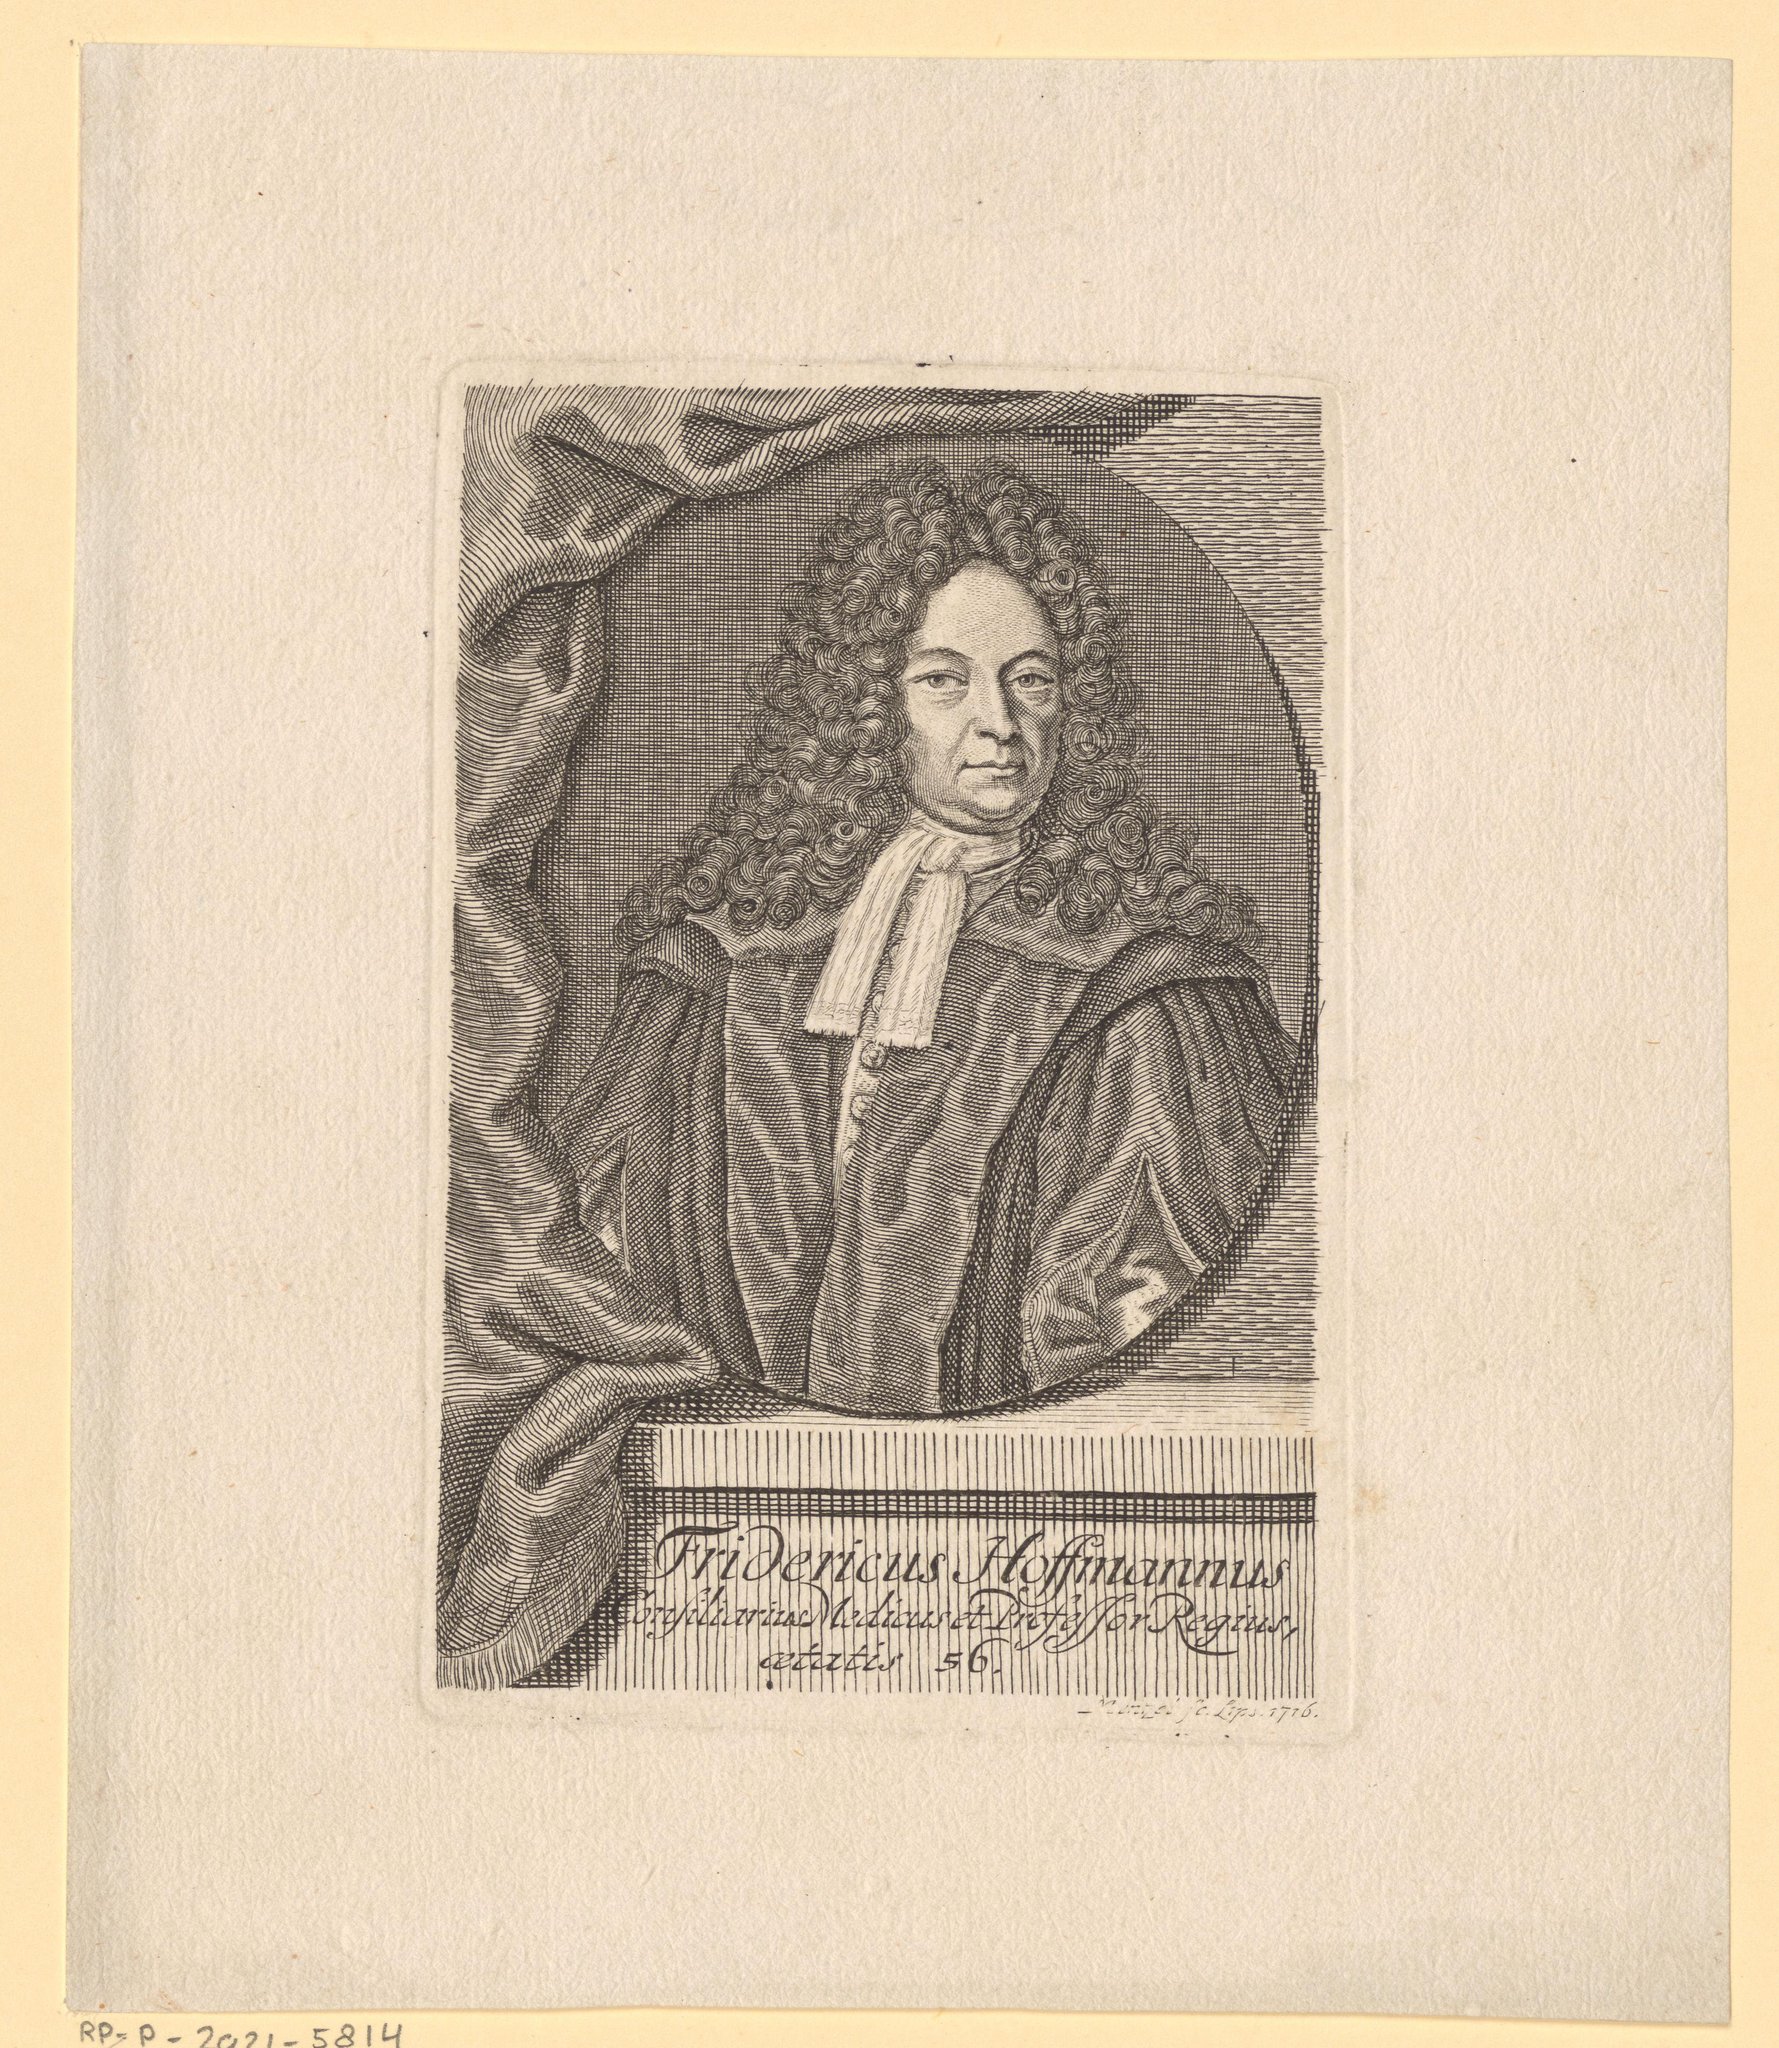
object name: print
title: Portret van Friedrich Hoffmann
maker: johann georg mentzel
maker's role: print maker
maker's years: 1677-1743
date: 1716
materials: paper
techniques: engraving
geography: leipzig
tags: historical persons, physician, doctor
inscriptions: date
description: Prent gebruikt in: Hoffmann, Friedrich. Gründliche Anweisung Wie ein Mensch vor dem frühzeitigen Tod und allerhand Arten Kranckheiten durch ordentliche Lebens-Art sich verwahren könne. Halle: Johann Gottfried Renger, 1715.